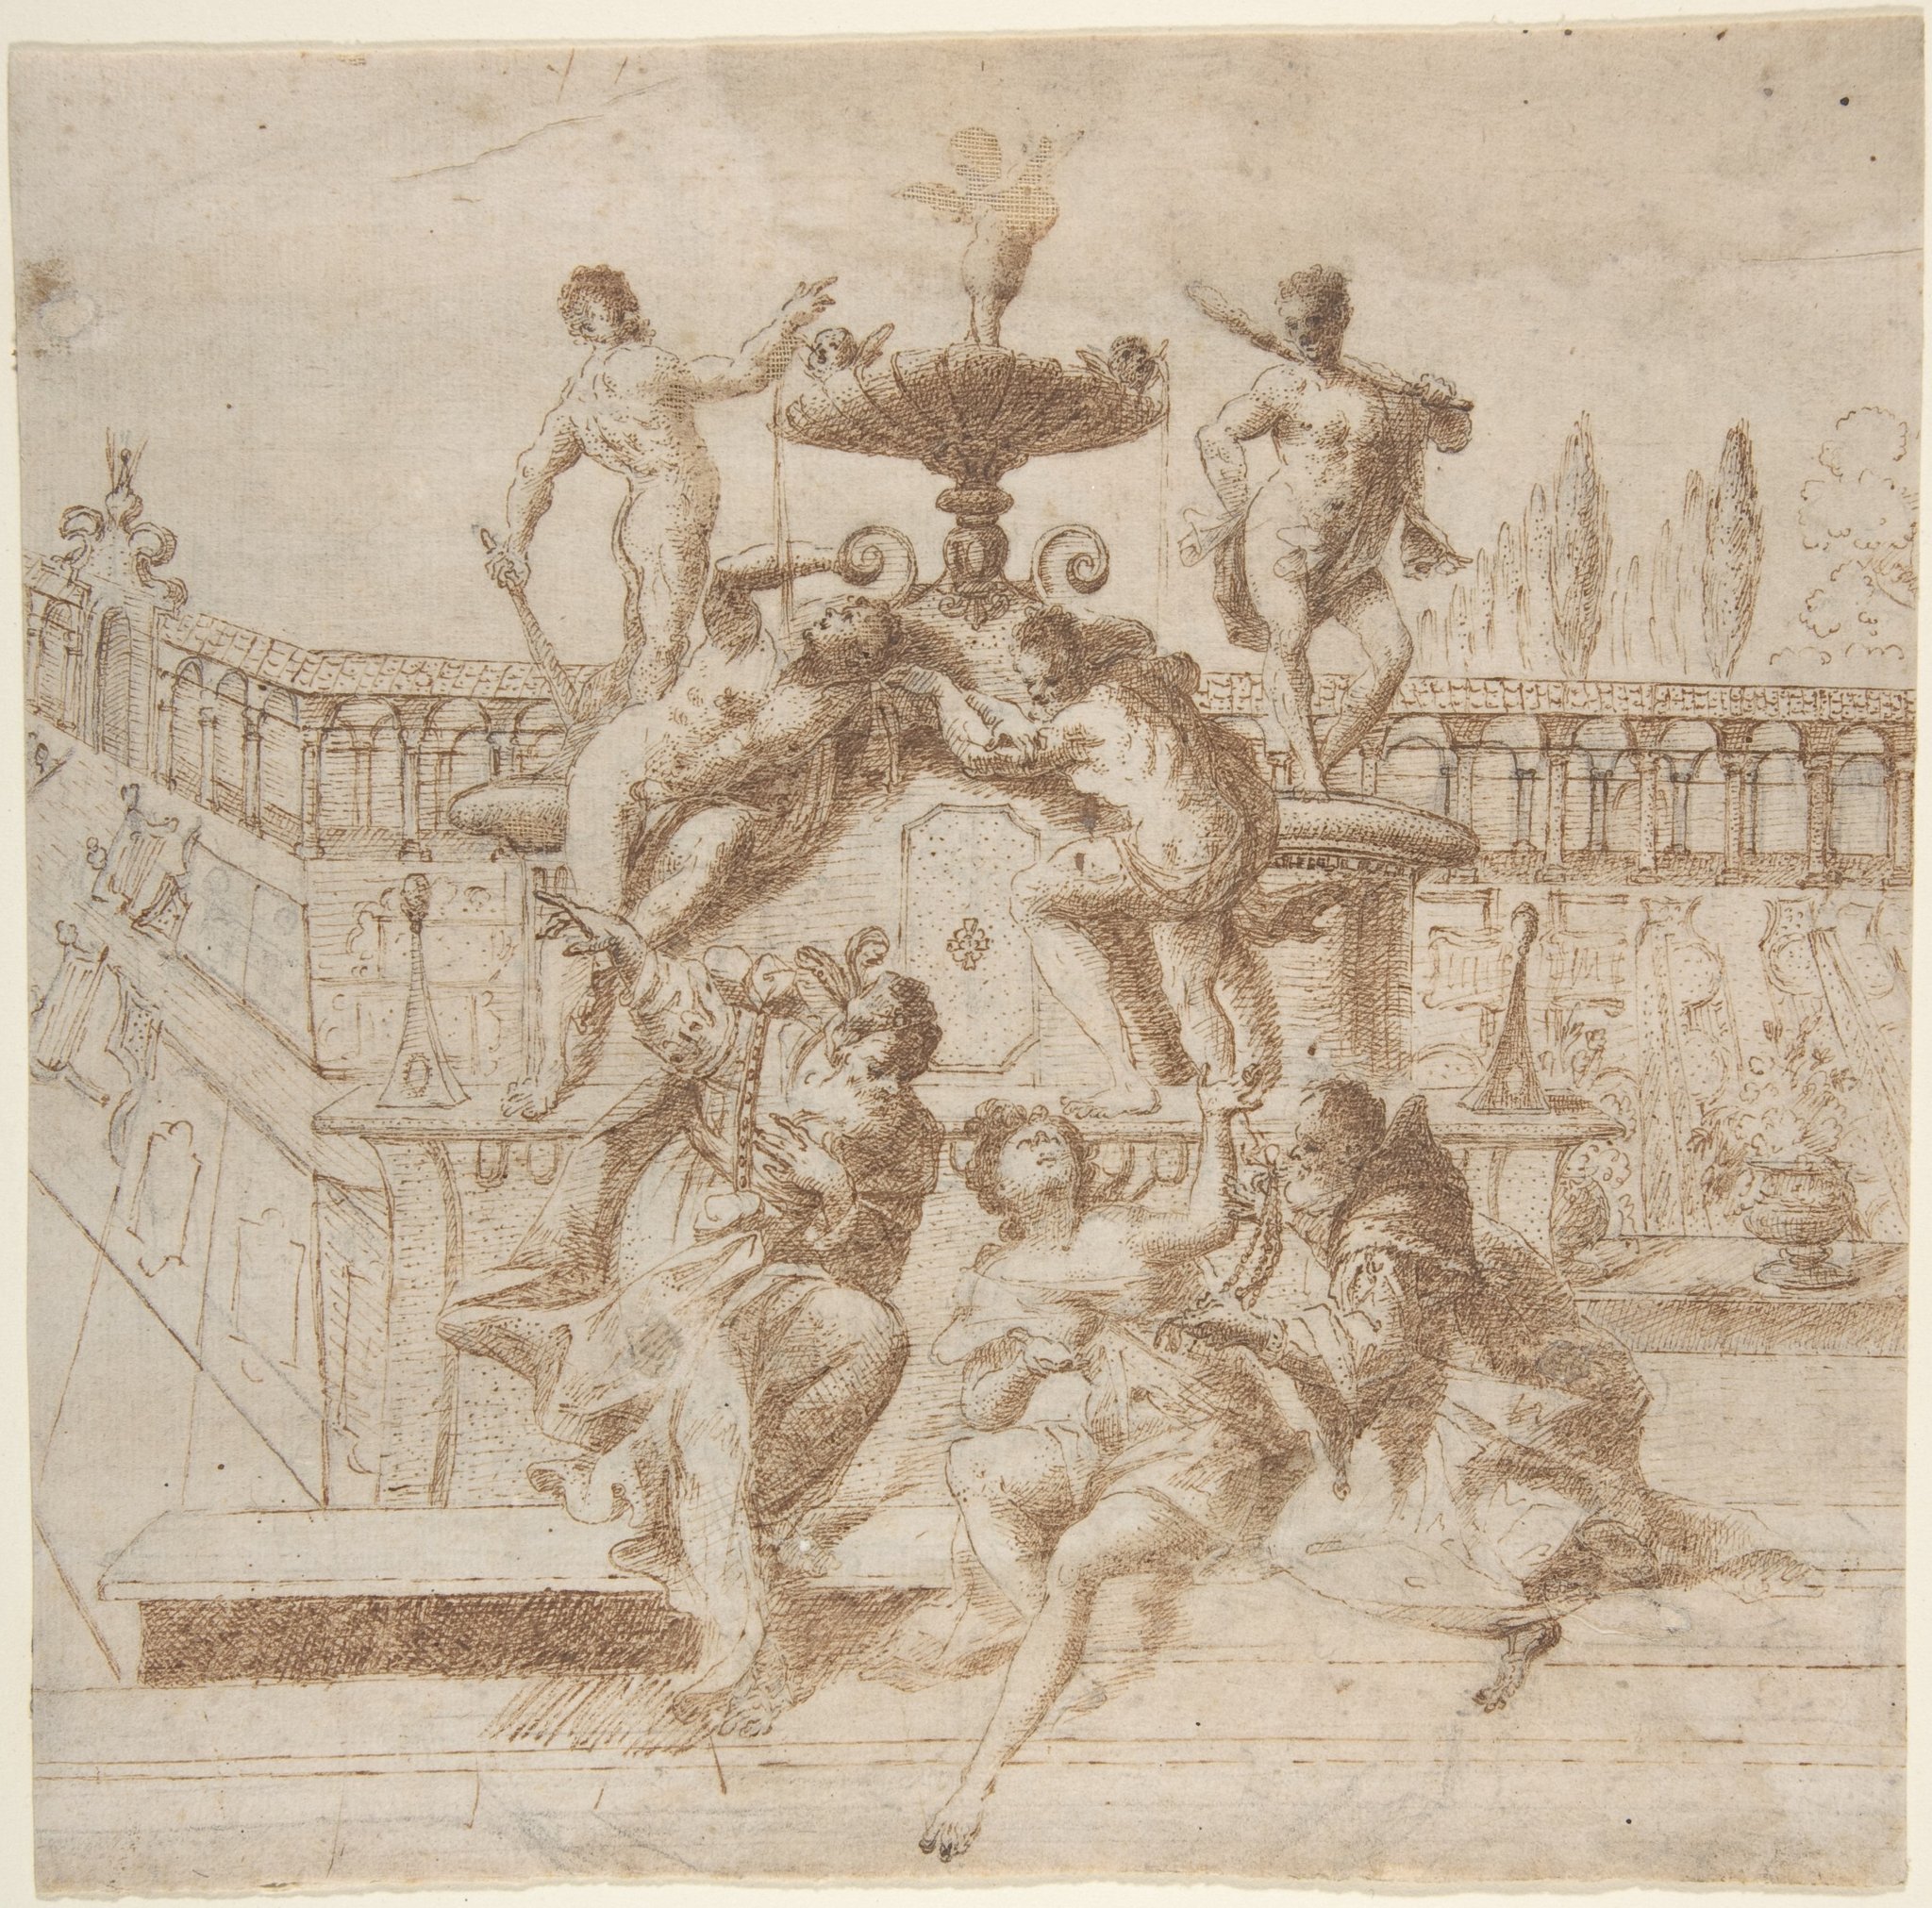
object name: drawing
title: Susanna and the Elders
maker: gregorio de' ferrari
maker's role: artist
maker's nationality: italian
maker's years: 1647-1726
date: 1647-1726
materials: chalk, graphite, ink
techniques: pen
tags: buildings,fountains,men,women